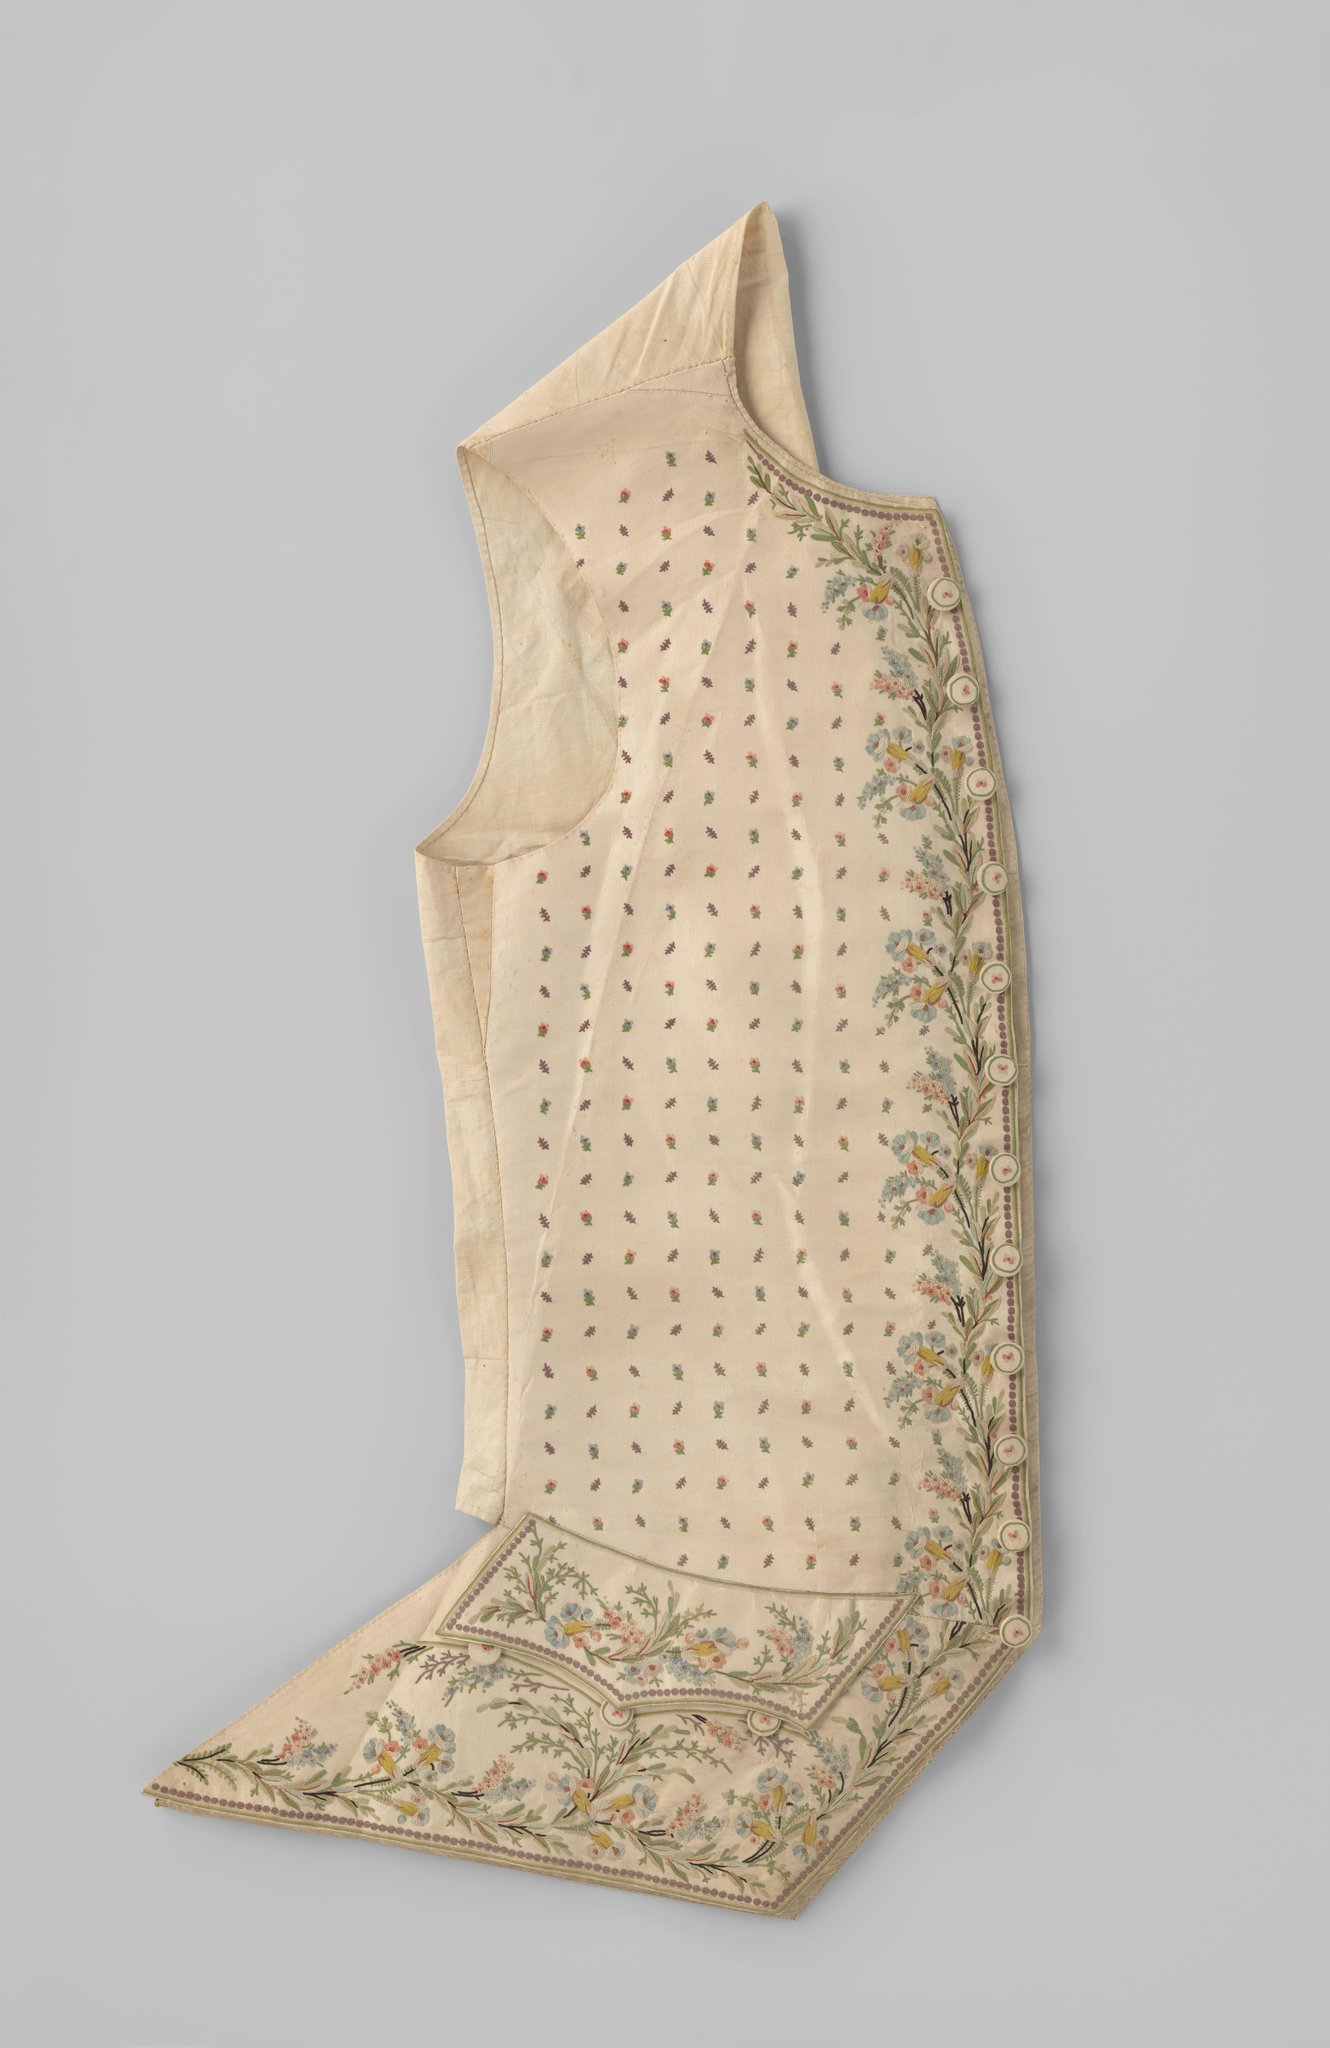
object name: clothing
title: Vest van witte zijde, geribd en met gekleurde zijden bloemen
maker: Anonymous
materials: cotton, linen, silk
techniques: embroidered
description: Vest van witte zijde, geribd en met gekleurde zijden bloemen en rand